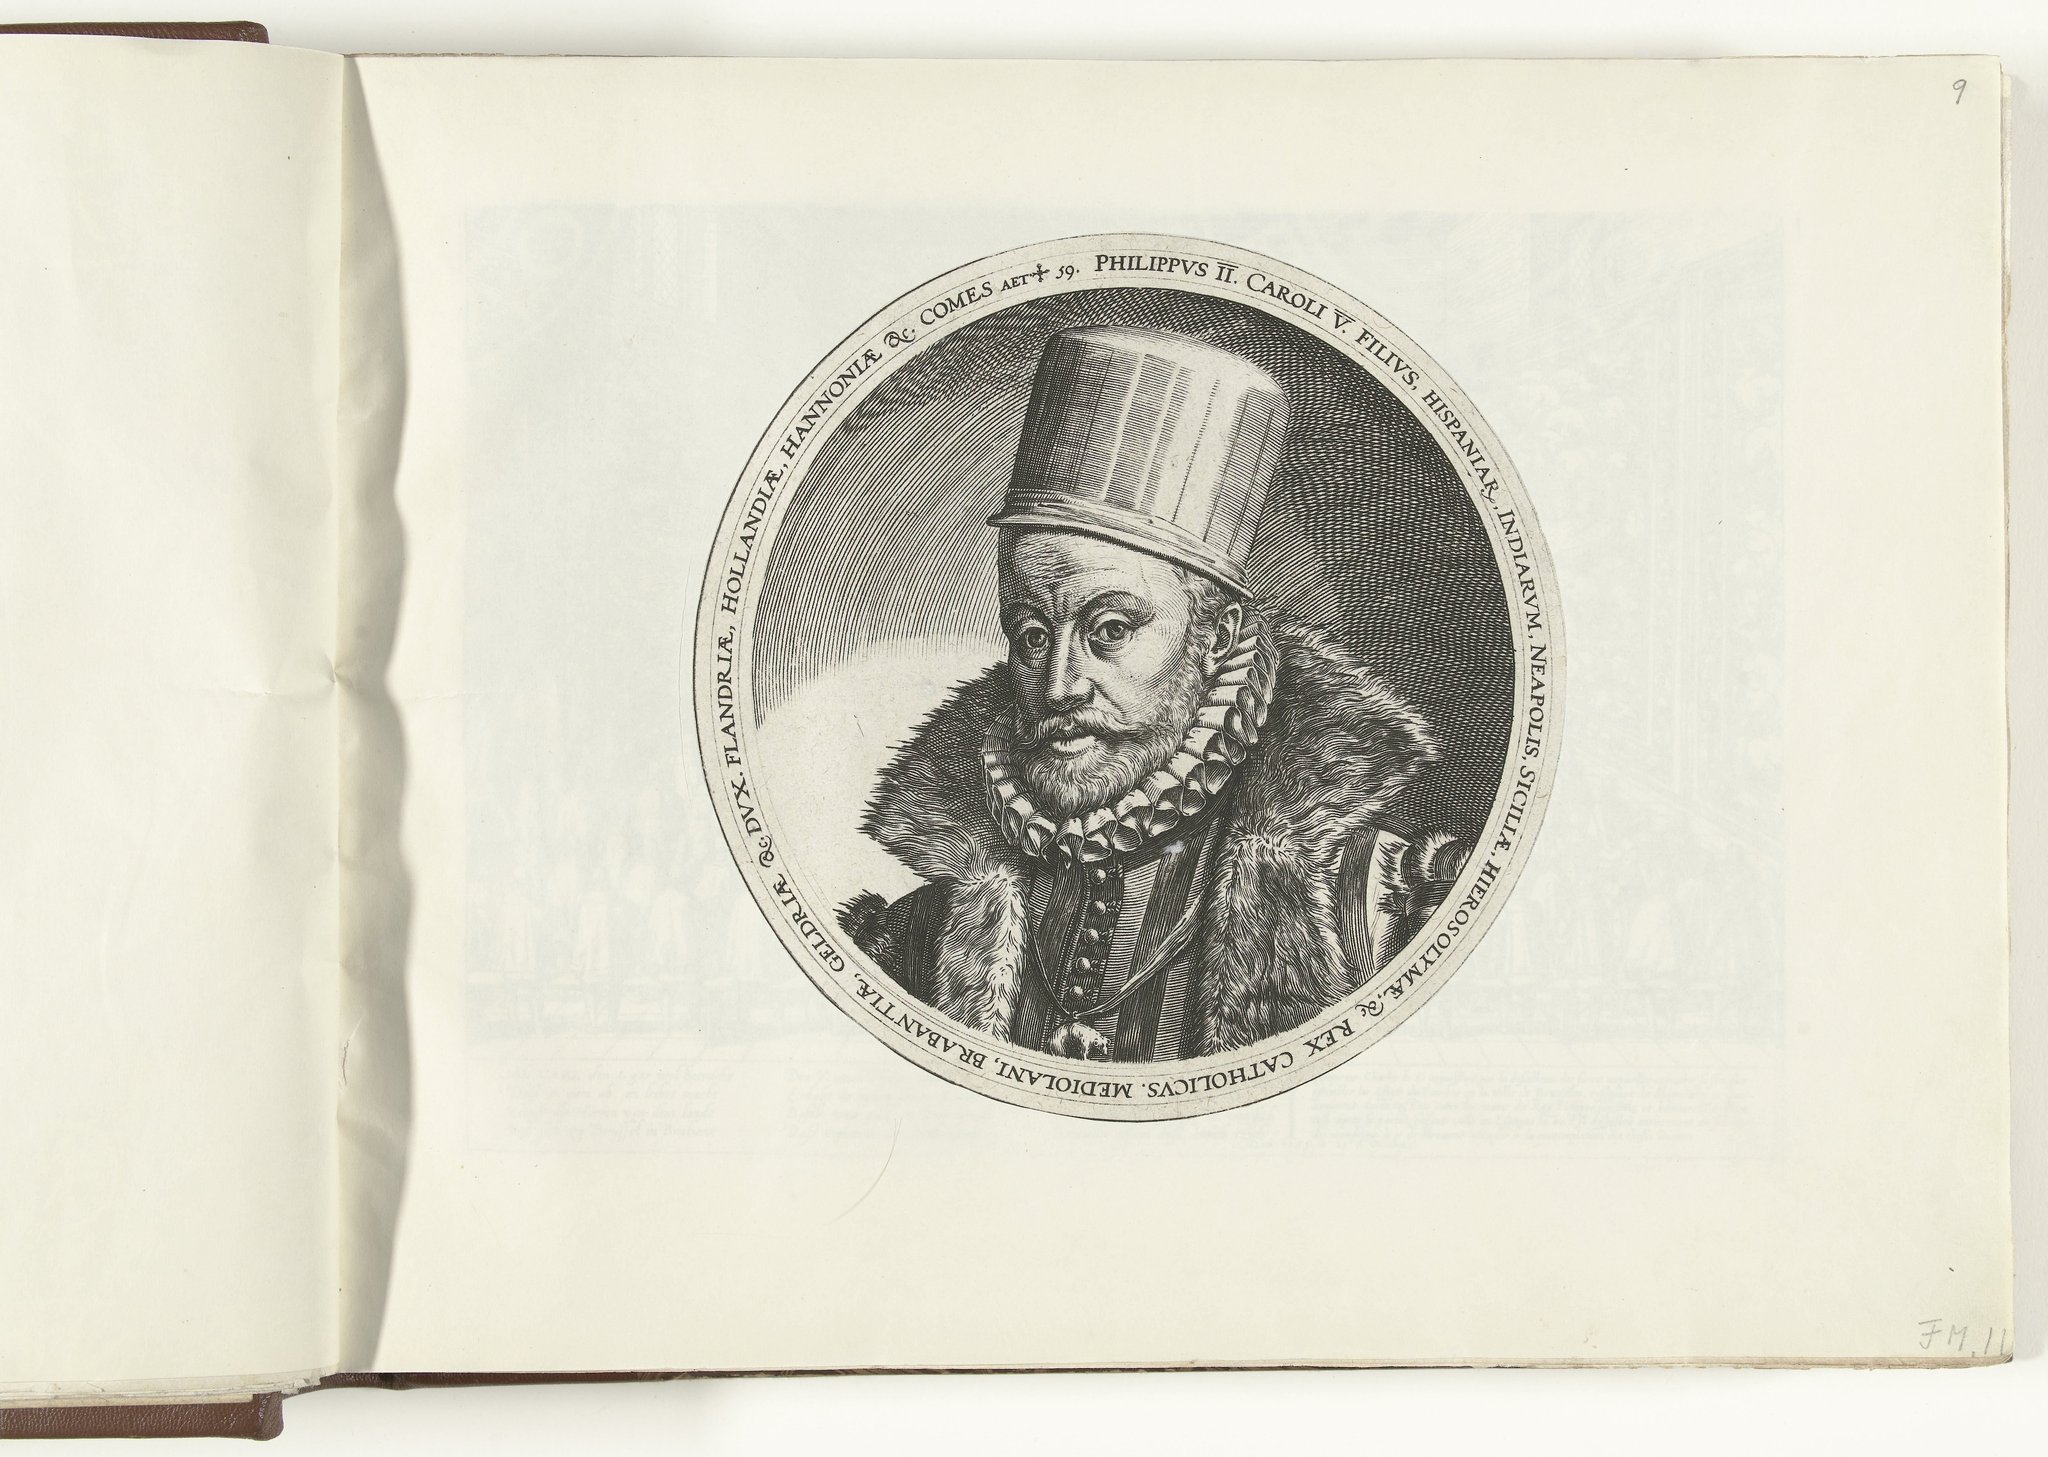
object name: album leaf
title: Portret van Filips II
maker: frans hogenberg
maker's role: print maker, publisher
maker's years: 1538-1590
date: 1586-1587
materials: paper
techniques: engraving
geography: cologne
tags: philip ii of spain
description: Naar het portret door Hieronymus Wierix gedateerd 1586 (Hollstein 2134). Eerst gebruikt als illustratie in: Michael Aitsinger, Belgici leonis chorographia, das ist ein newe Landt Beschreibung des Belgischen Lewen, in 17 Provincien des gantzen Niderlandts außgetheylet. Keulen: Frans Hogenberg, 1587.